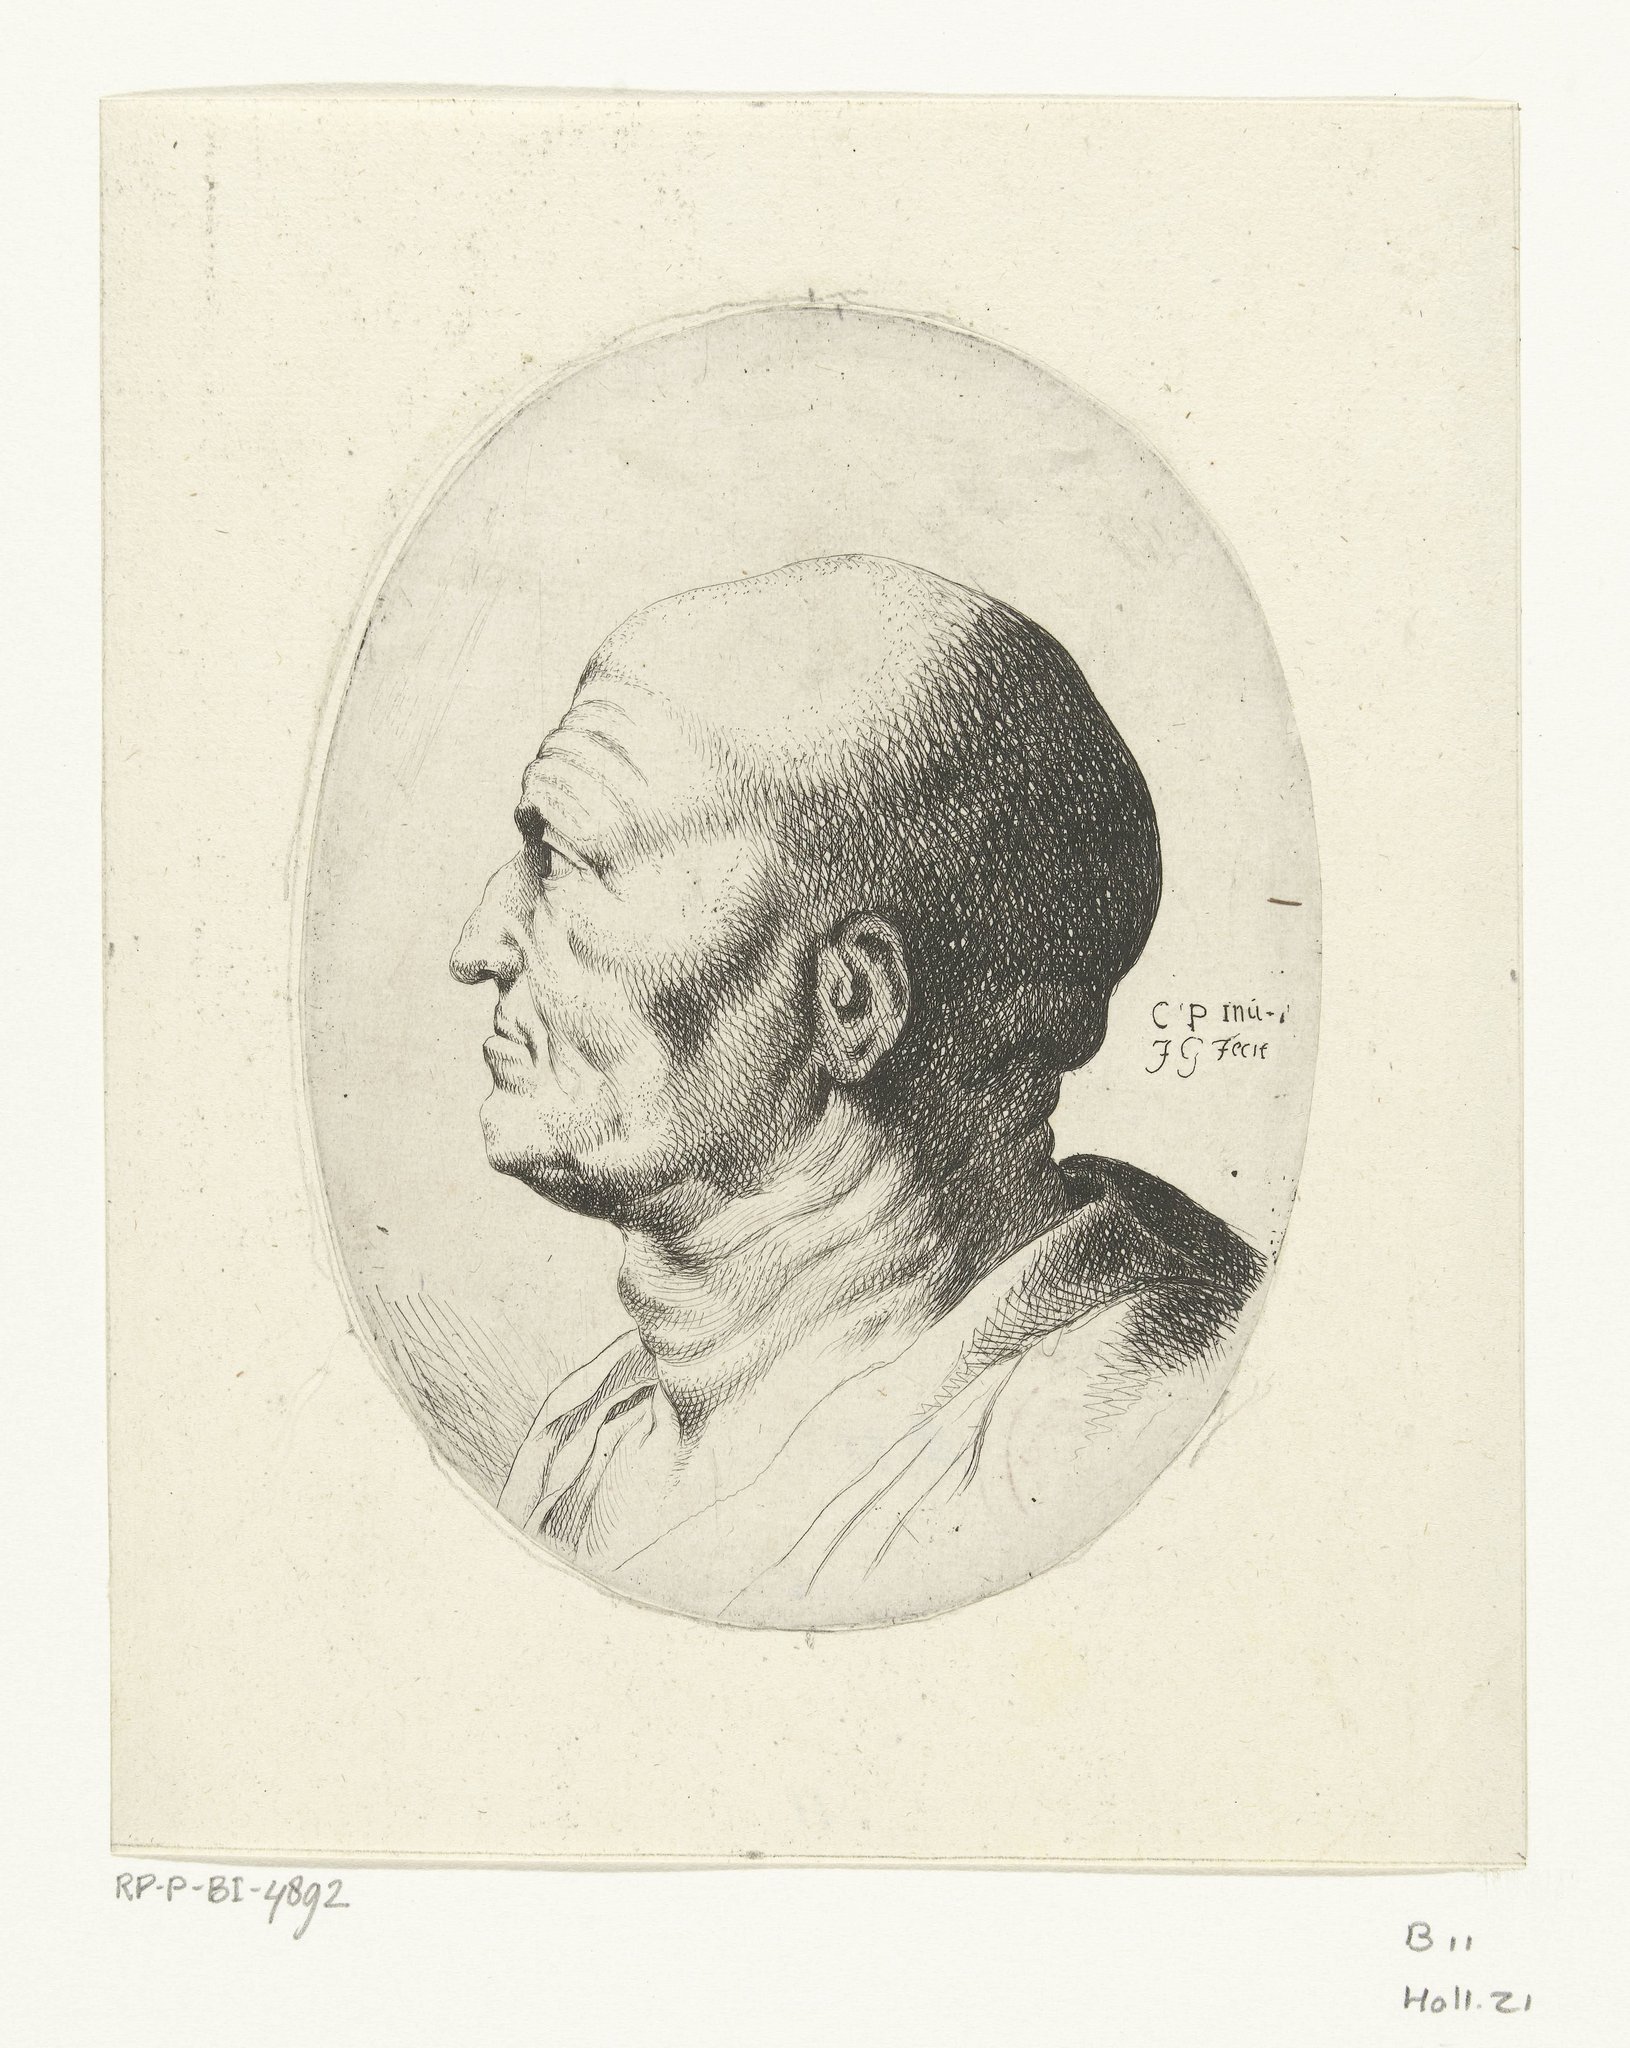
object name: print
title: Buste van oude man met kaal hoofd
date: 1613-1661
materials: paper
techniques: etching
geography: netherlands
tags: old man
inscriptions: collector's mark: Lugt 240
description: Prent naar ontwerp van Cornelis van Poelenburch.